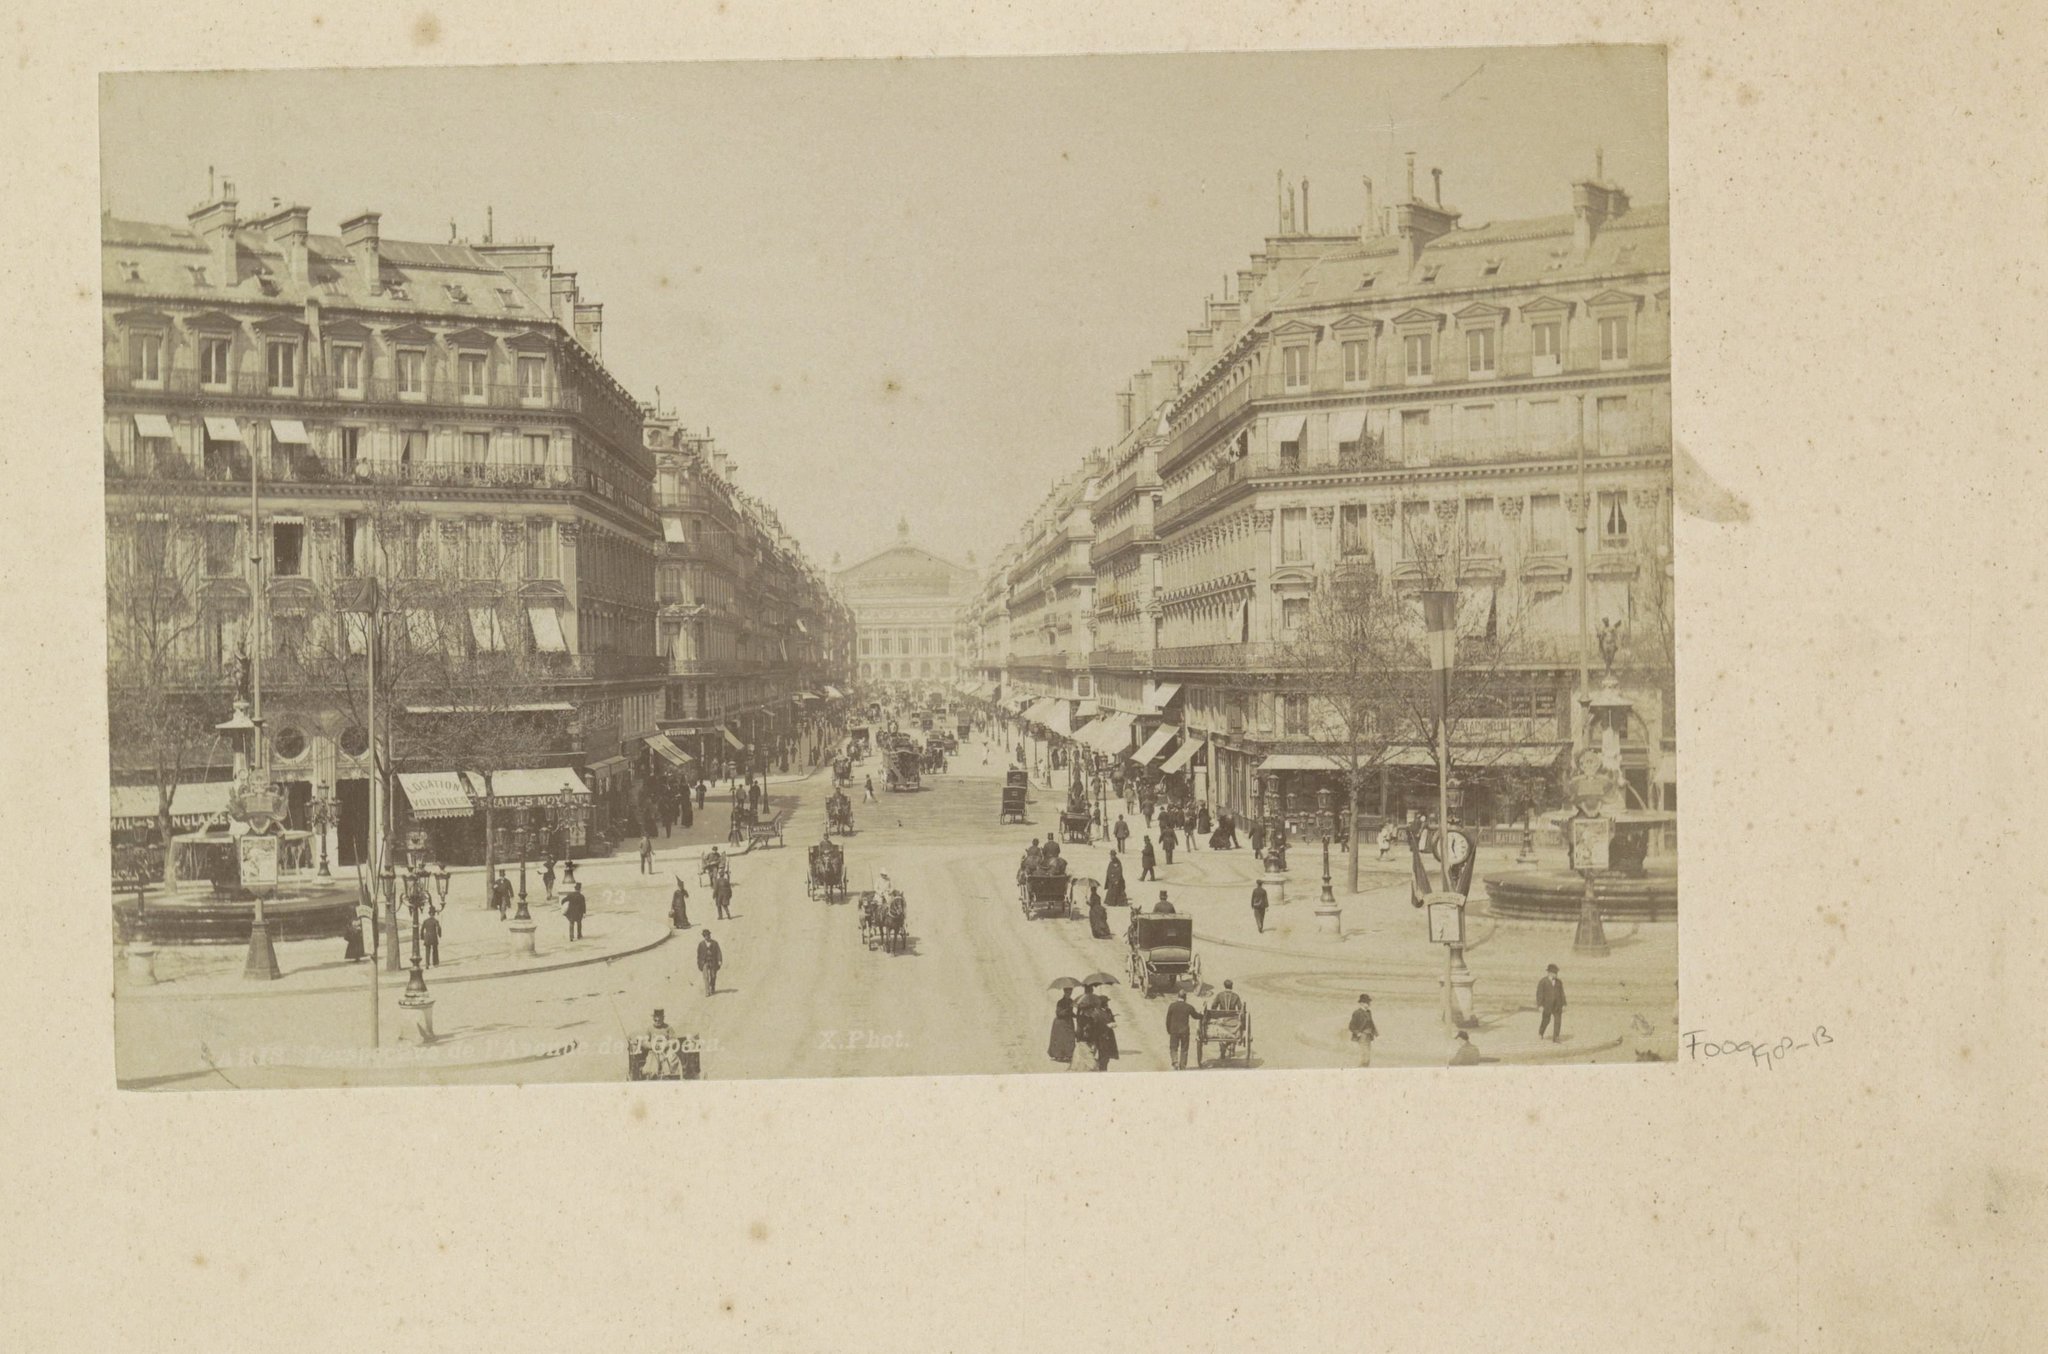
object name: photograph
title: Avenue de l'Opéra in Parijs gezien richting het operagebouw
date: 1880-1890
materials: paper, photographic support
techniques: albumen print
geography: paris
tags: street (+ city(-scape) with figures, staffage)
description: Onderdeel van Reisalbum met foto's van bezienswaardigheden in Frankrijk, Griekenland en Turkije.